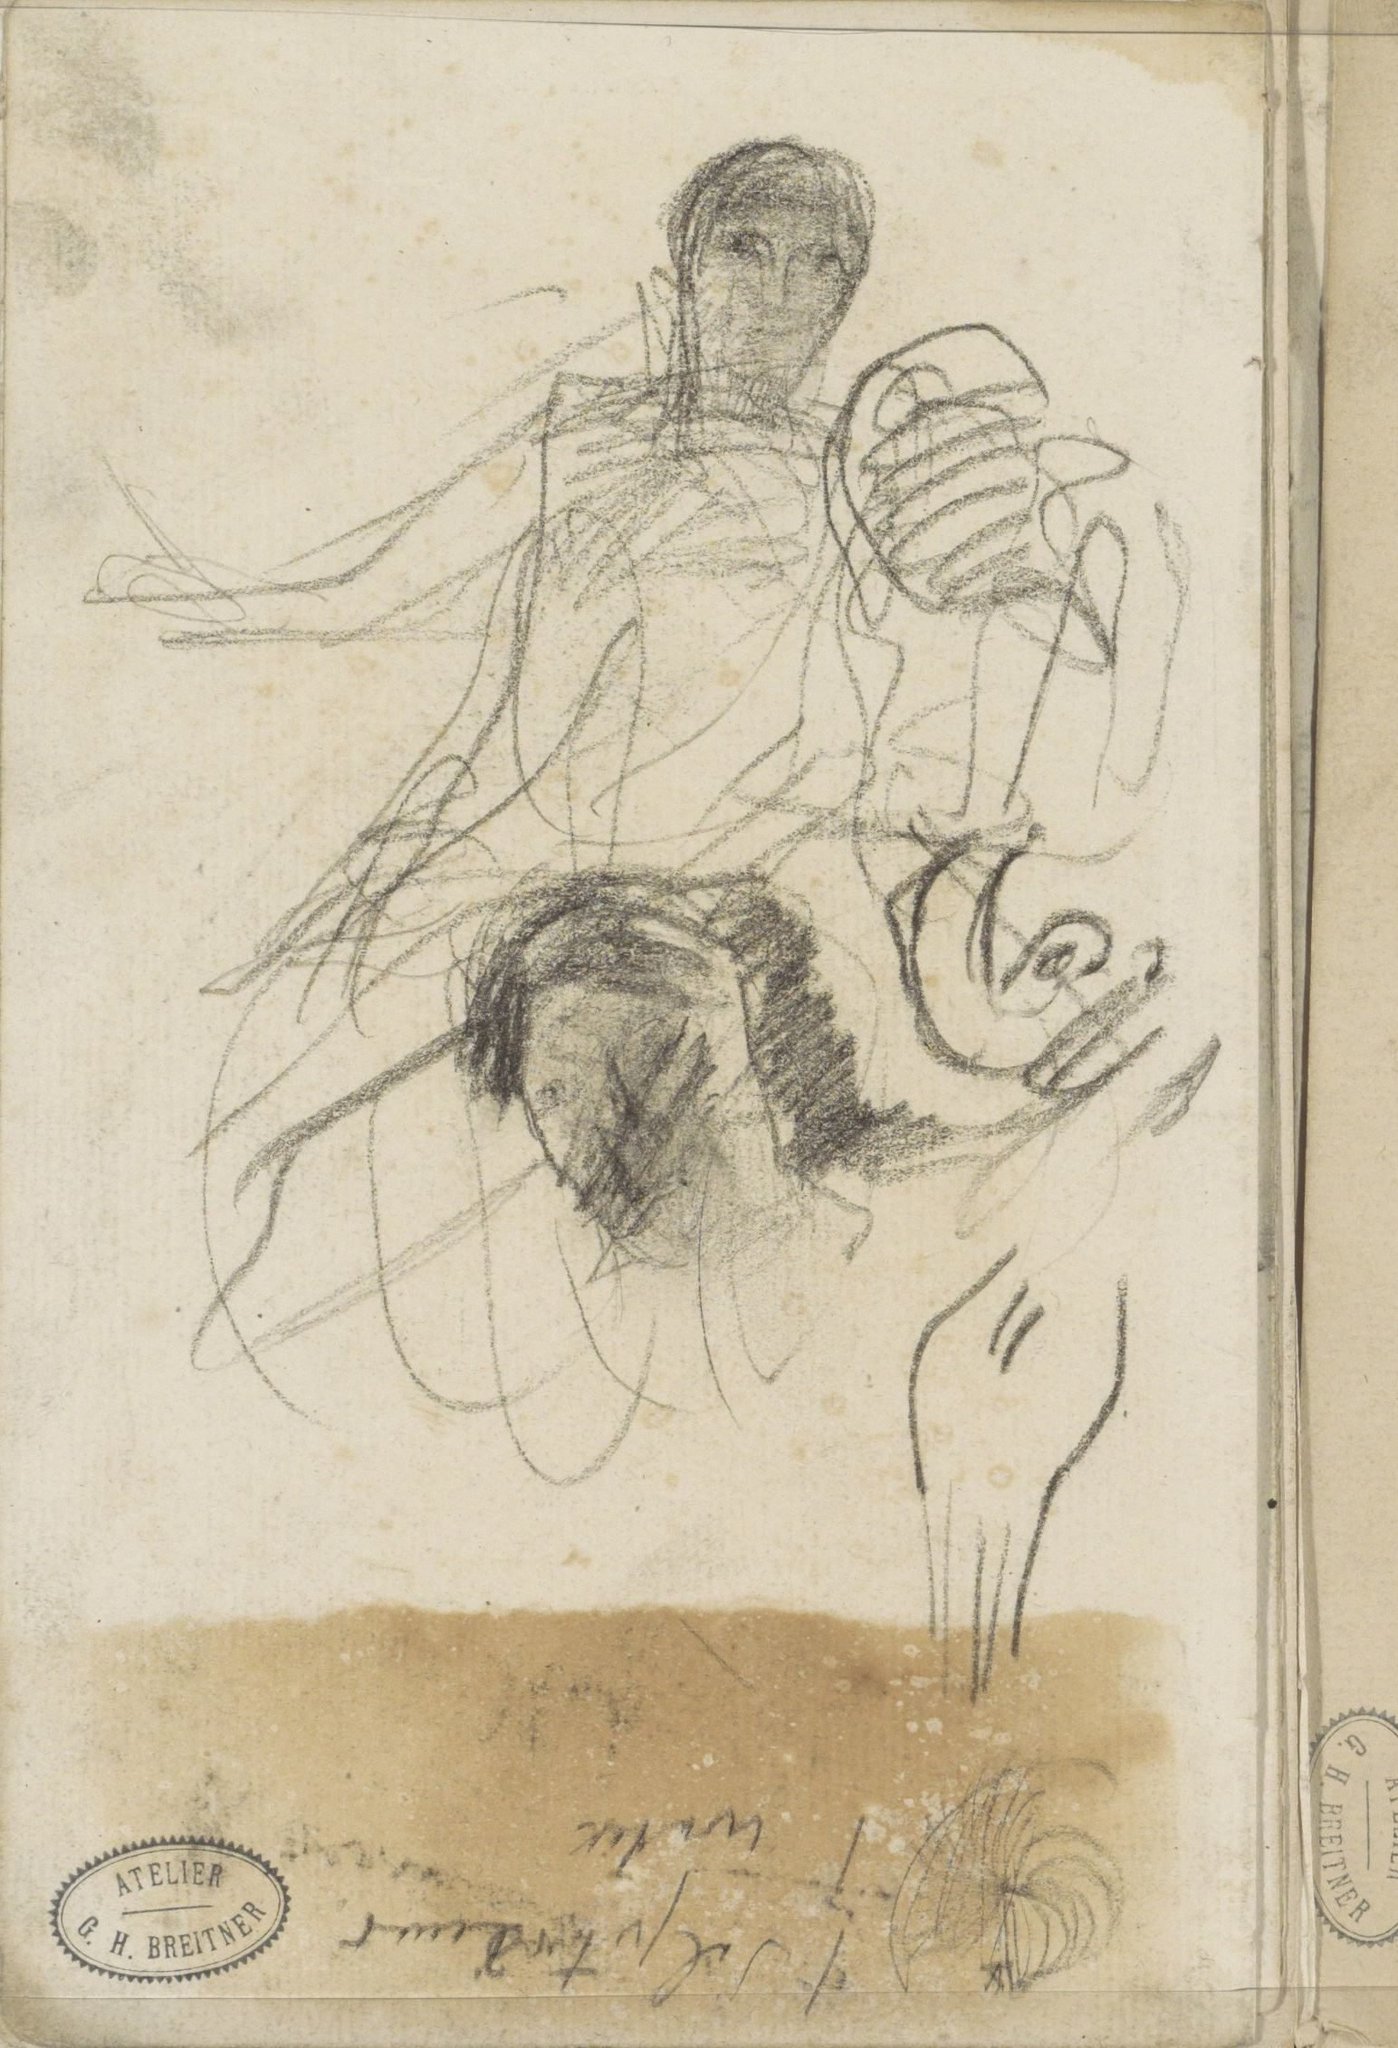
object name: sketchbook leaf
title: Studies van vrouwen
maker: george hendrik breitner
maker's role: draughtsman, painter, print maker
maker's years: 1857-1923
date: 1886-1923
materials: chalk, paper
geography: amsterdam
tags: adult woman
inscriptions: workshop stamp: Lugt 291d, annotation: ‘[...]’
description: Pagina 39 uit een schetsboek met 19 bladen en 9 losse tekeningen.